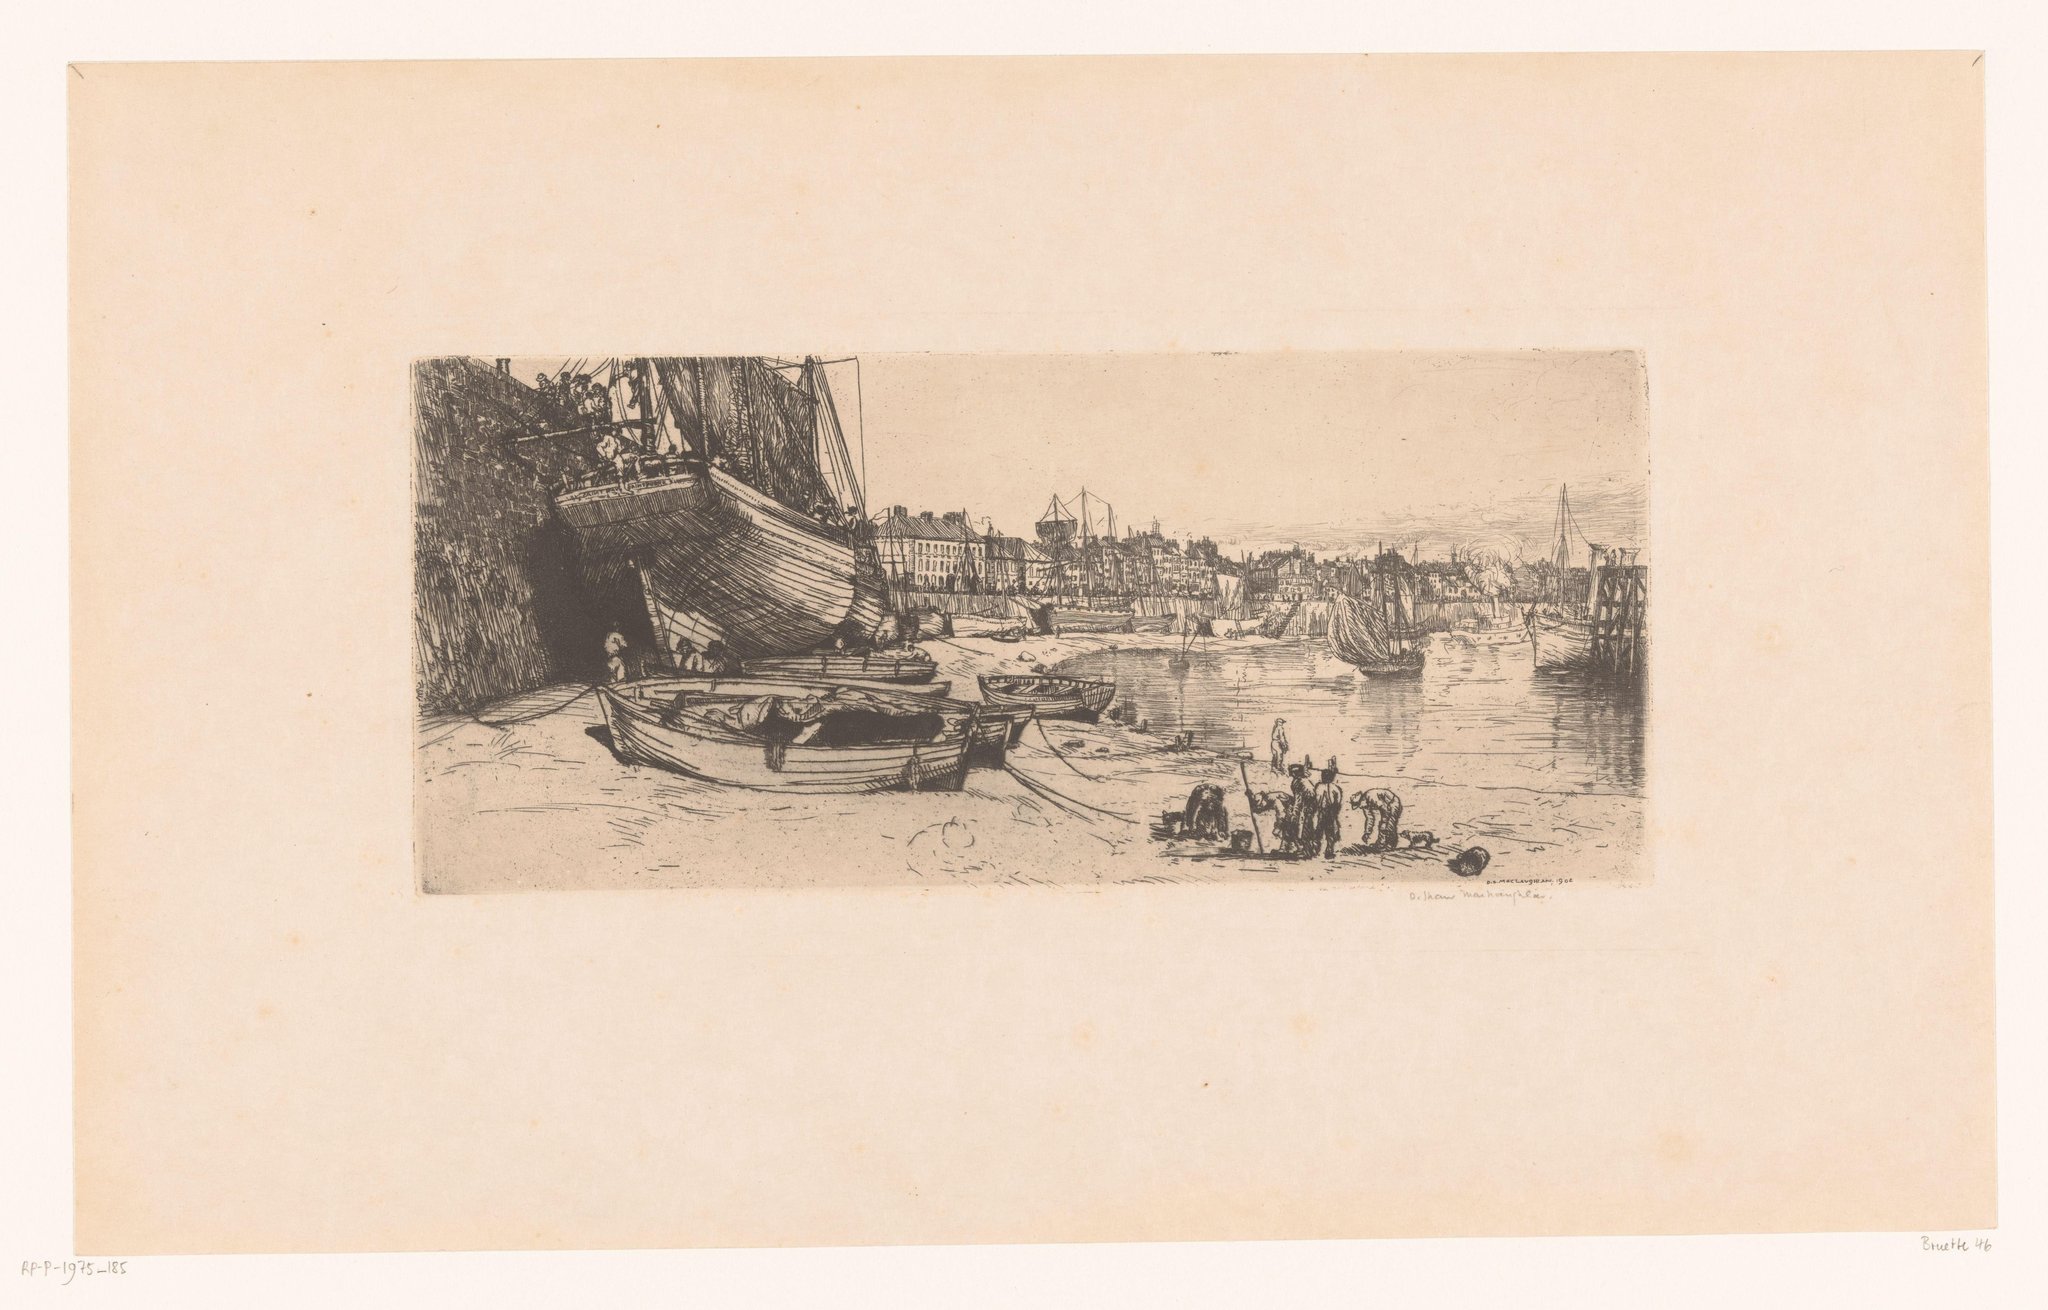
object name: print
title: Le Port de Boulogne-sur-Mer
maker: donald shaw maclaughlan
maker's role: painter, print maker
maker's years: 1876-1938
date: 1902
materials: paper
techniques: etching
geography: france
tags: harbour, ships, boats on land, beached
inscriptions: collector's mark: Lugt 2760, collector's mark: Lugt 2228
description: Gezicht te Boulogne-sur-Mer met schepen en kleinere boten die met laag water droog komen te liggen. Op de voorgrond een groep figuren.